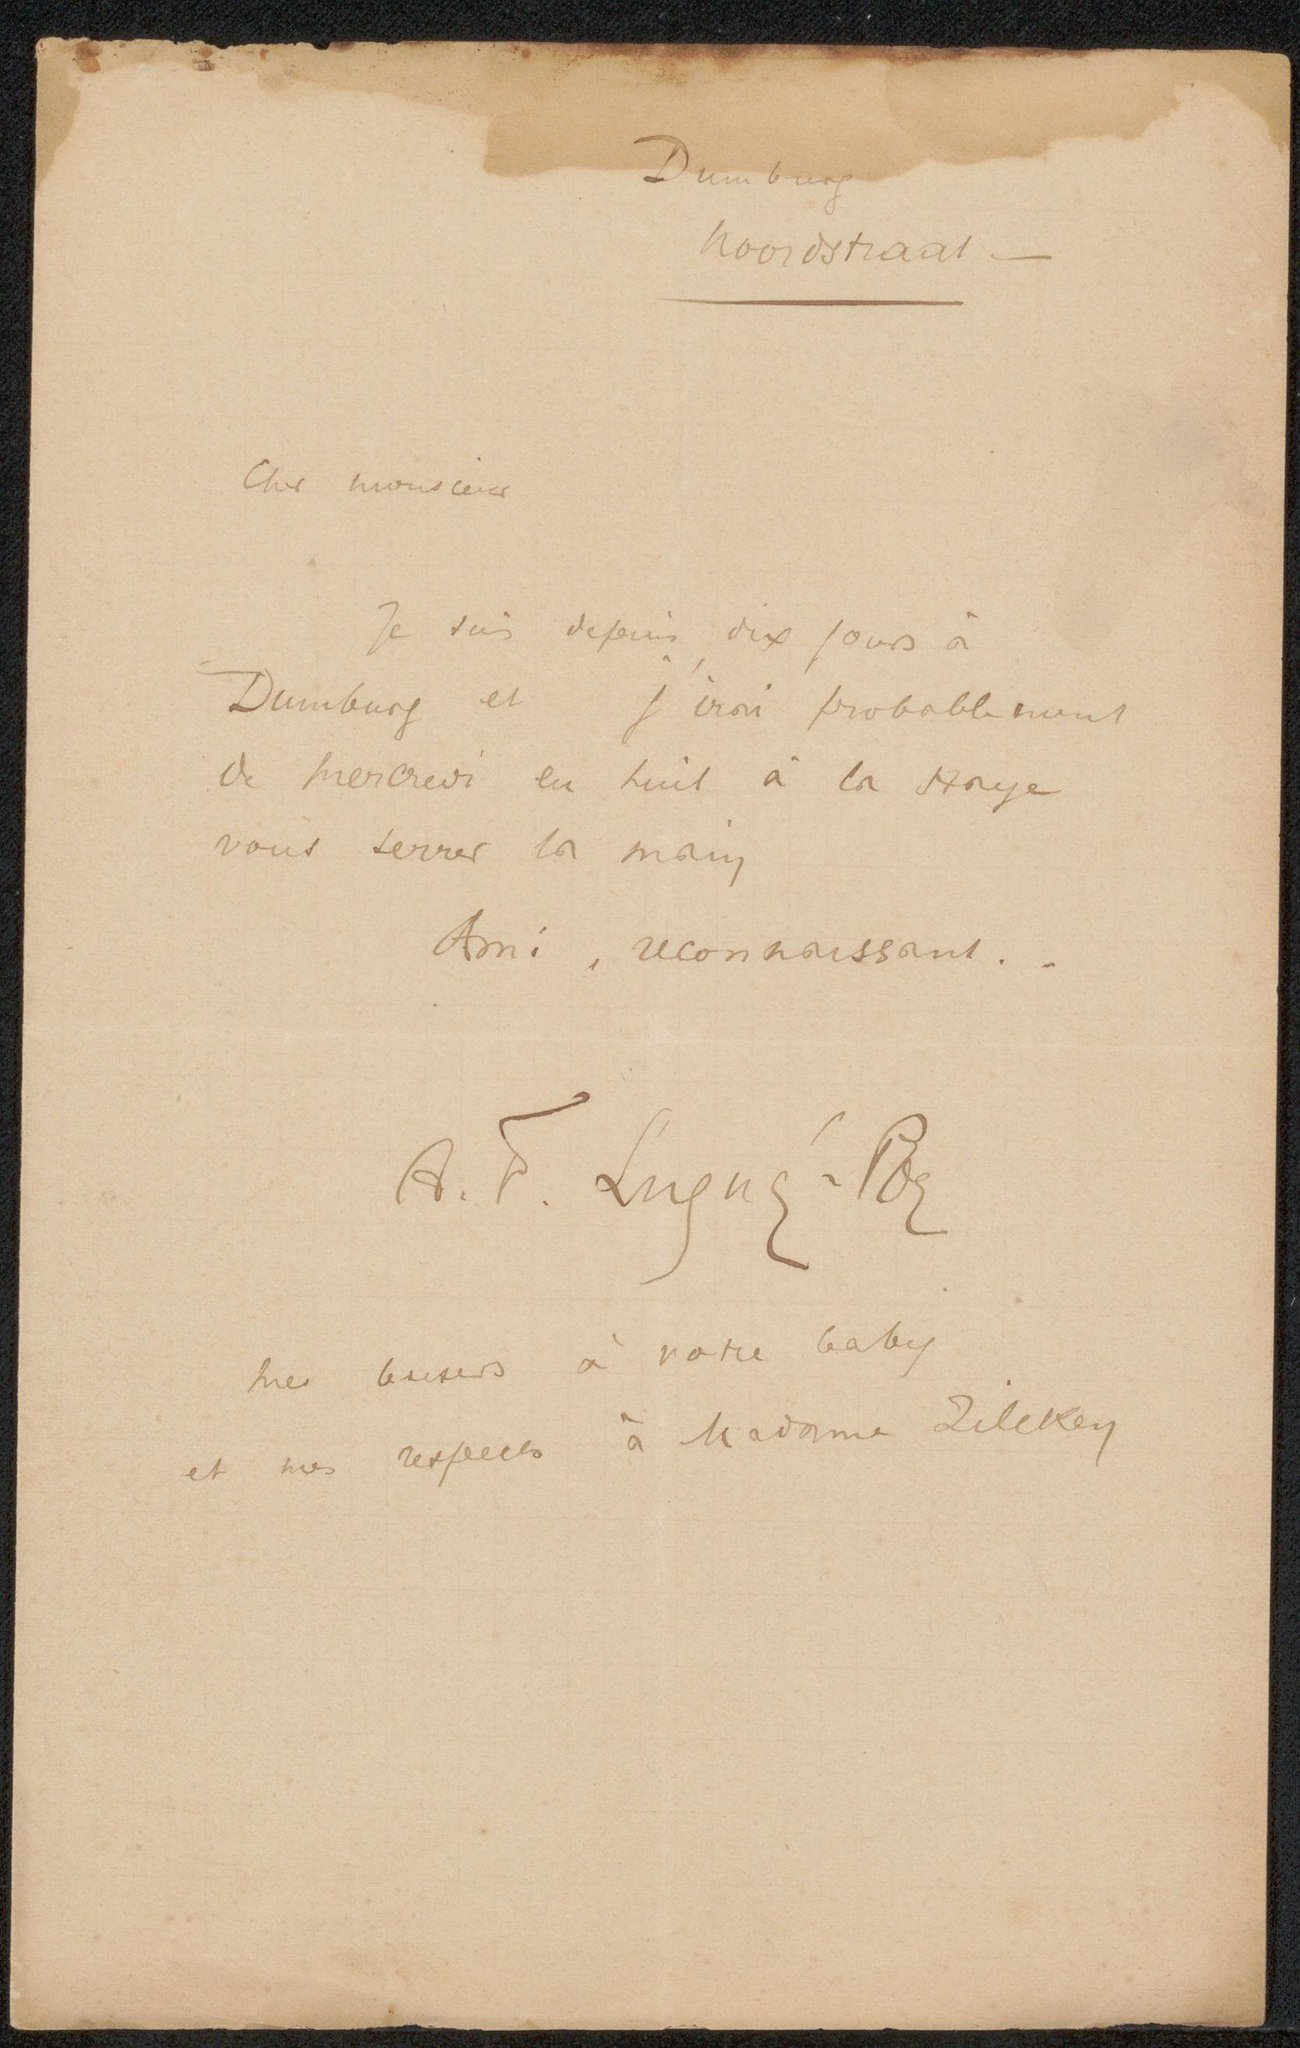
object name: letter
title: Brief aan Philip Zilcken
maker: lugné-poe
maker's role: acteur, theaterdirecteur, theatervormgever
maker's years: 1869-1940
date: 1879-1930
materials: ink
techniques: pen, writing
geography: domburg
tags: painter, draughtsman, philip zilcken, the hague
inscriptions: collector's mark: ‘RPK’